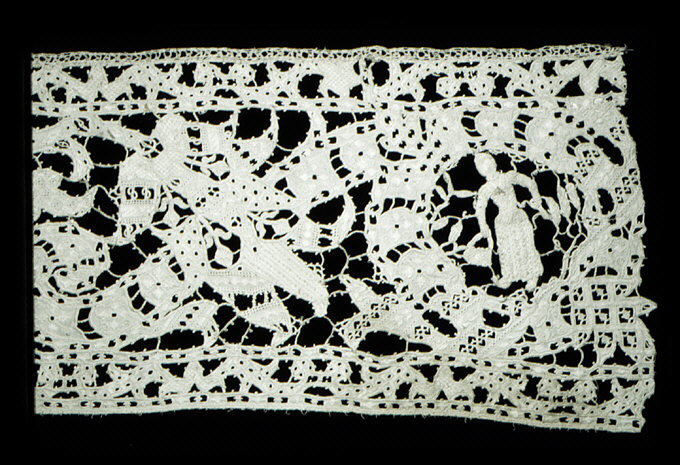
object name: band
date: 1501-1600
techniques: embroidery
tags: human figures